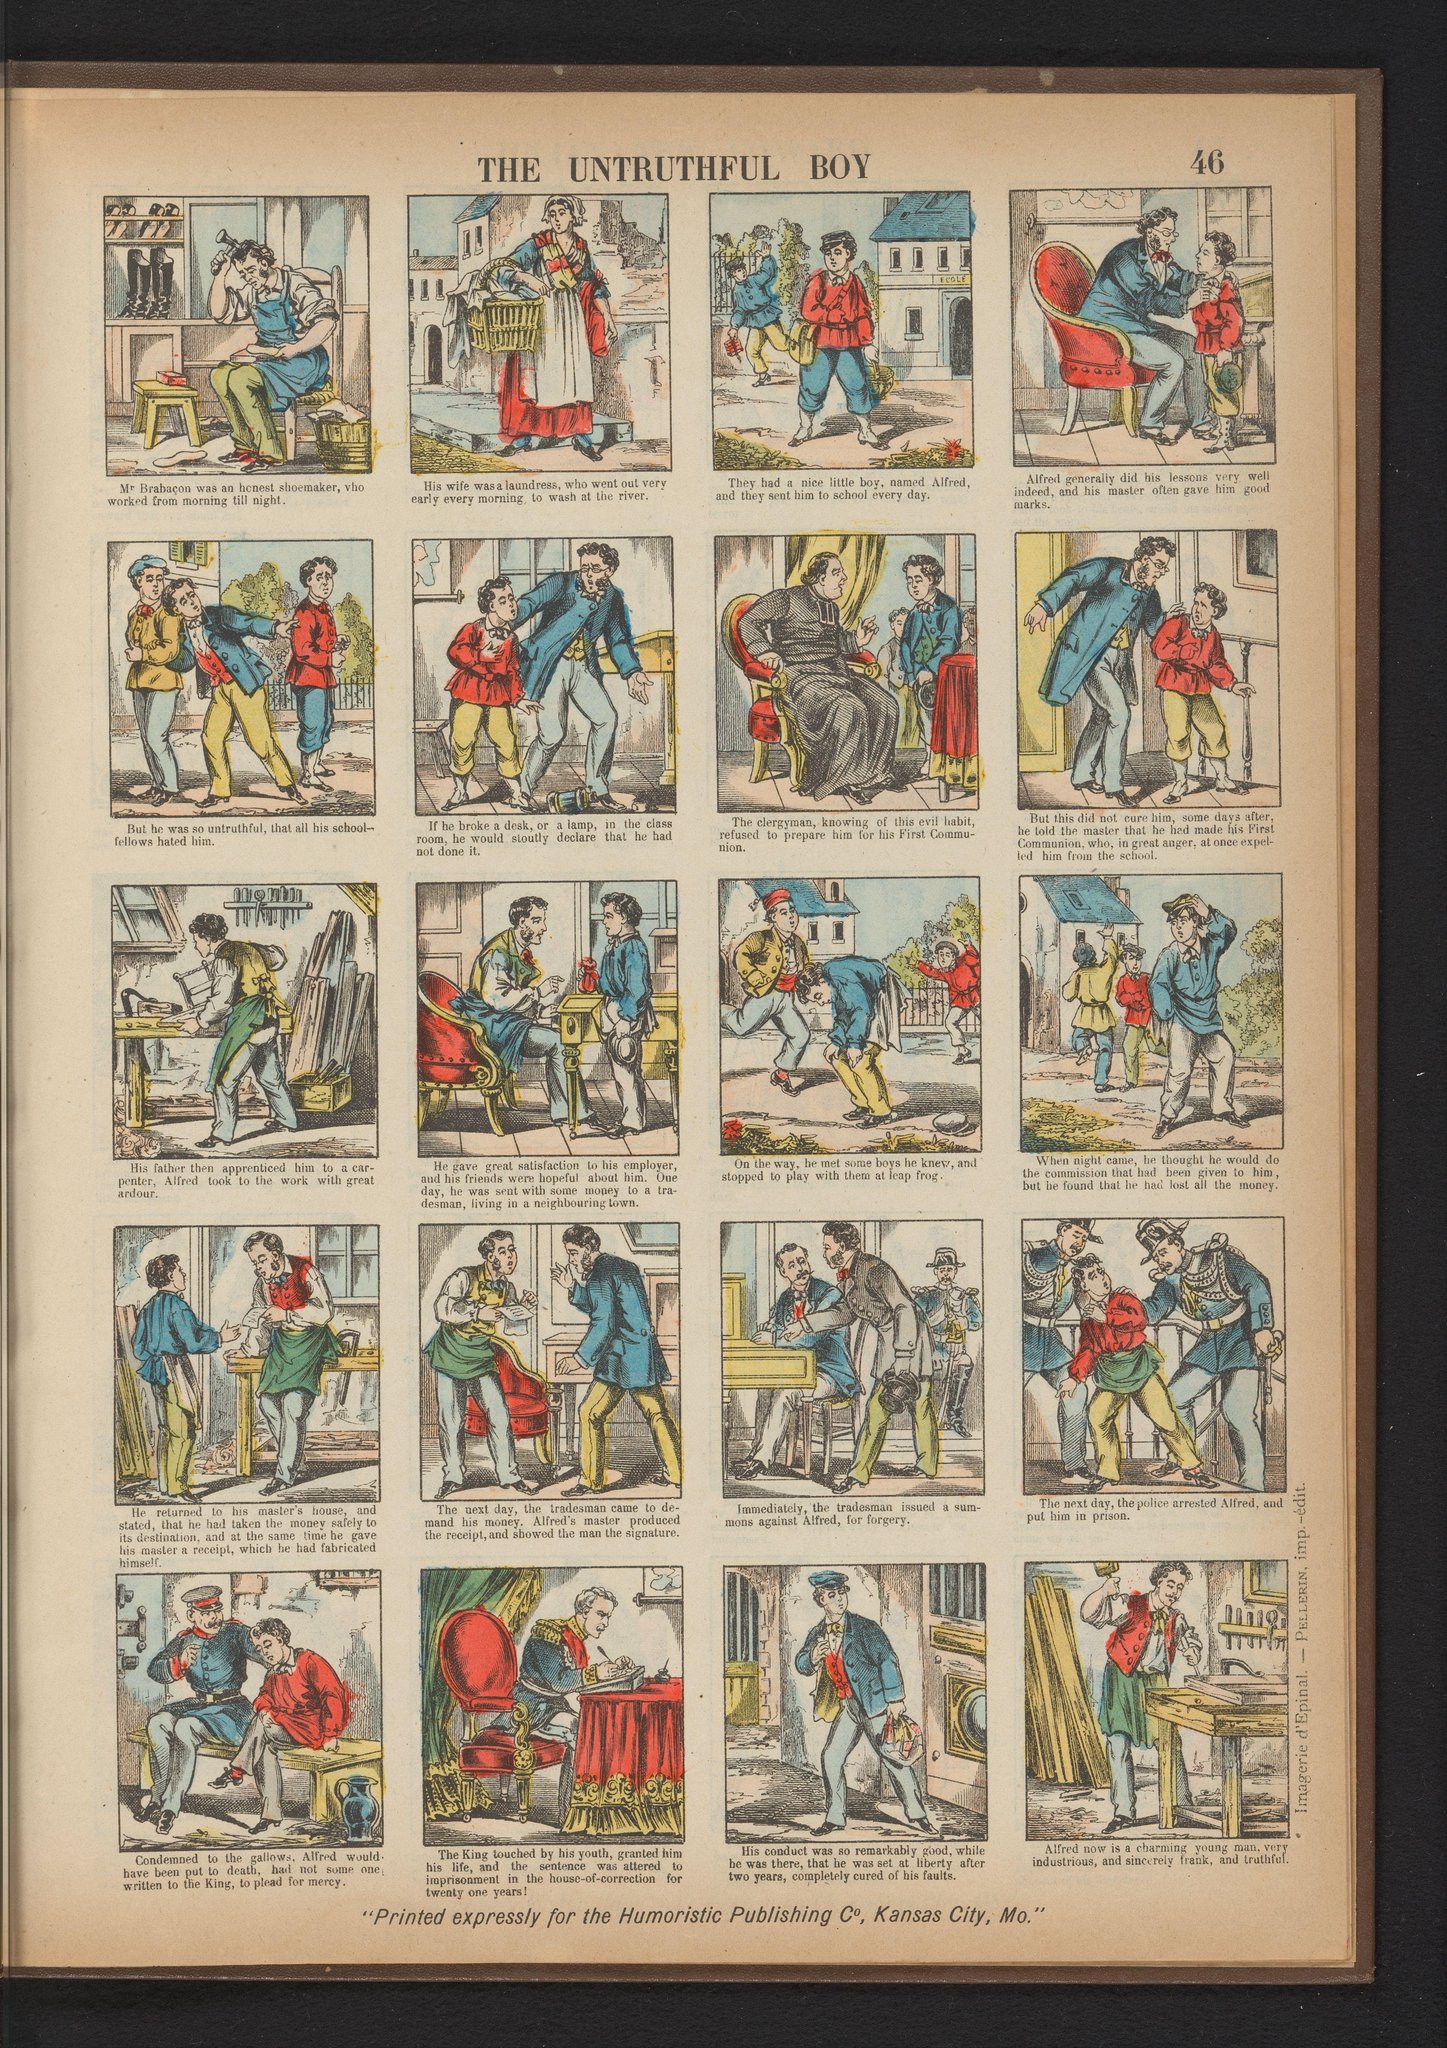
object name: popular print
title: Sprookjes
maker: Anonymous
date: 1893-1894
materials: paper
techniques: colour, letterpress printing, lithograph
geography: epinal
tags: boy (child between toddler and youth), tales and fairy tales, lie; 'bugia' (ripa)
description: Blad met zestien voorstellingen over de gevolgen van liegen voor Alfred. Onder elke voorstelling een onderschrift in het Engels. Deze prent maakt deel uit van een album.